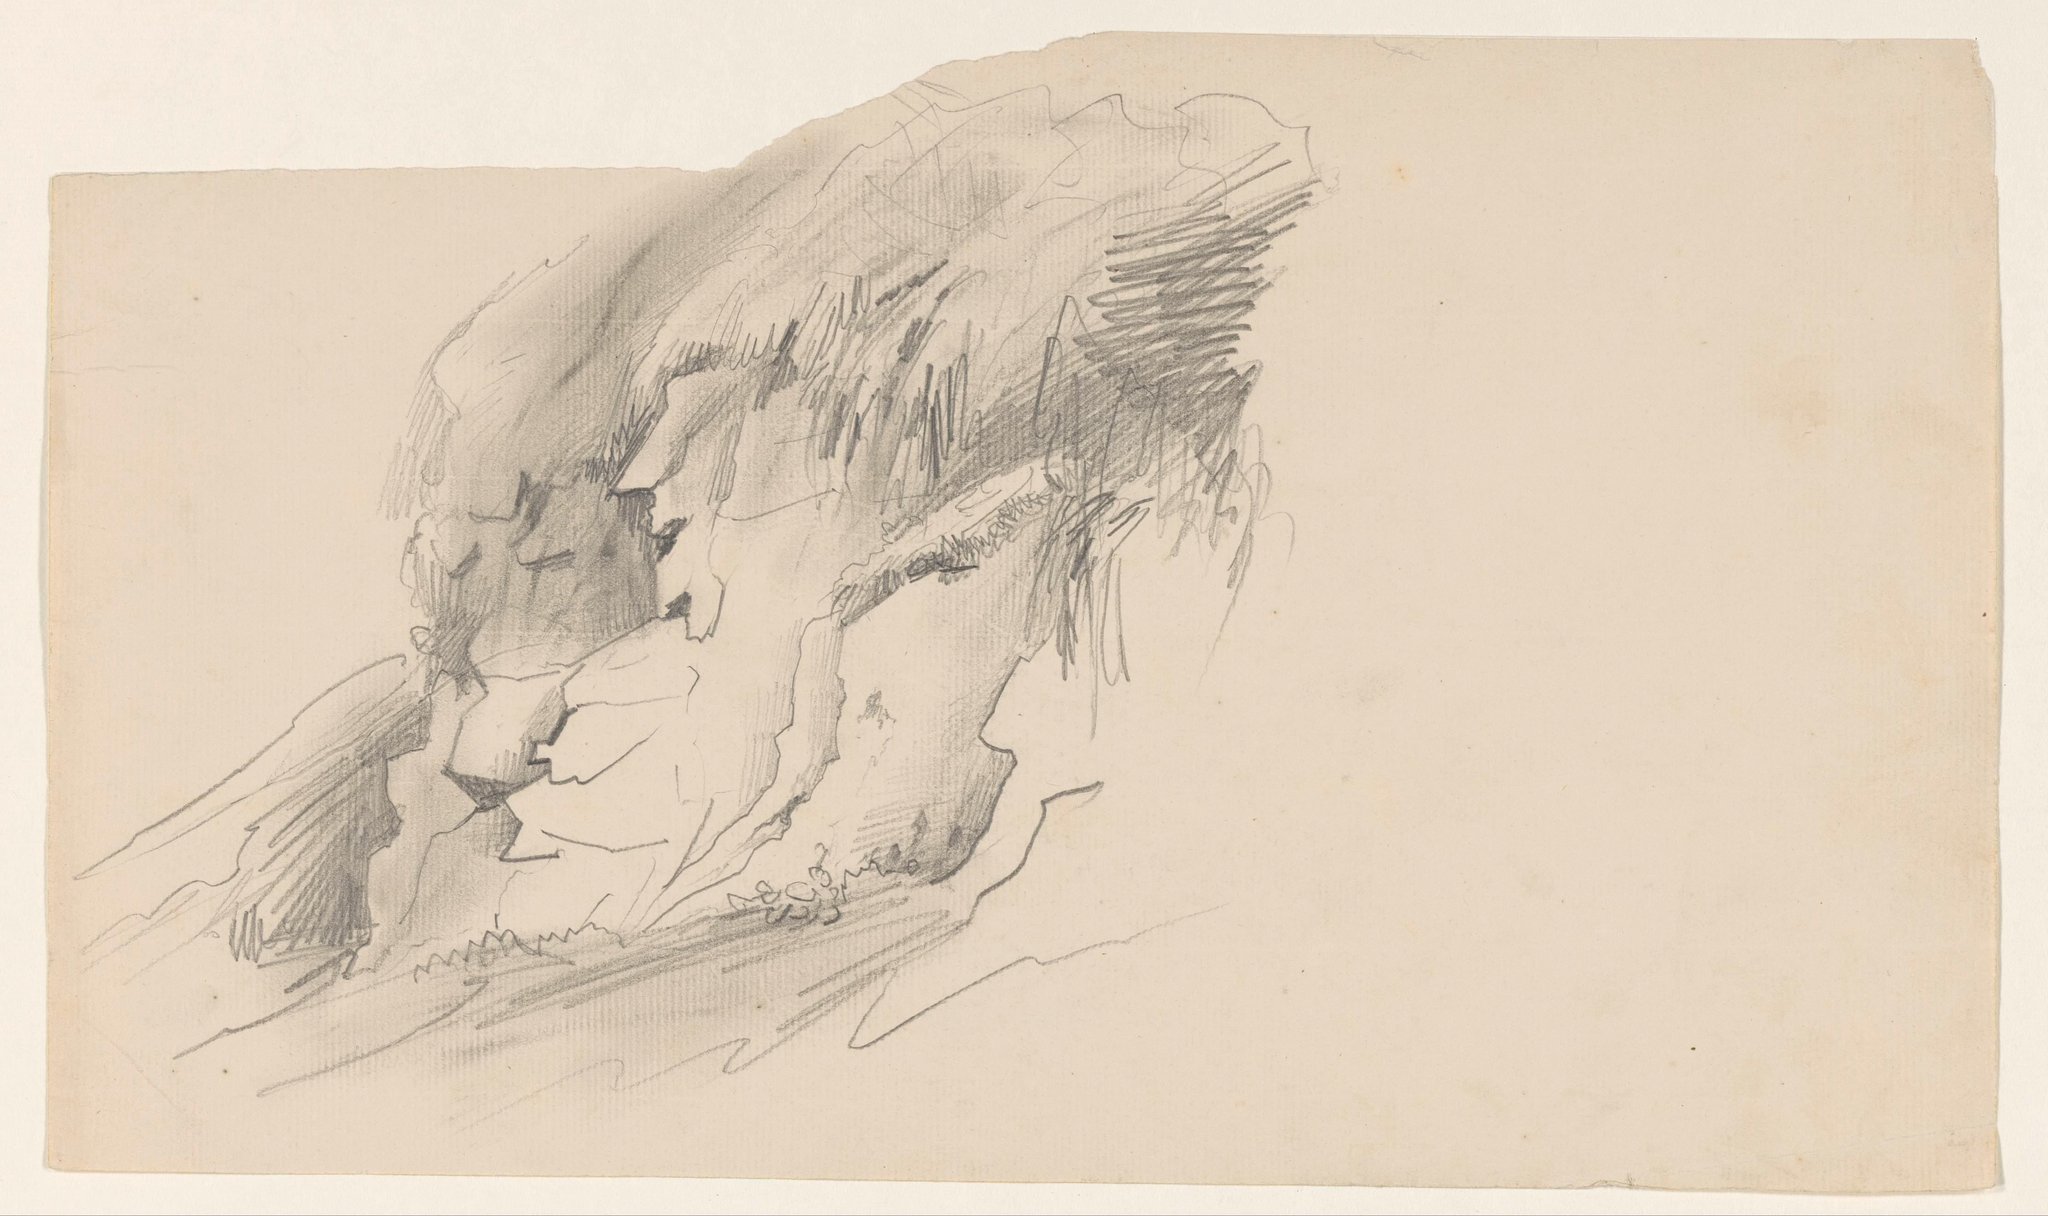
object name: drawing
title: Rotsen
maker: johannes tavenraat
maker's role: draughtsman, painter, print maker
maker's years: 1809-1881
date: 1819-1881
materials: paper, pencil